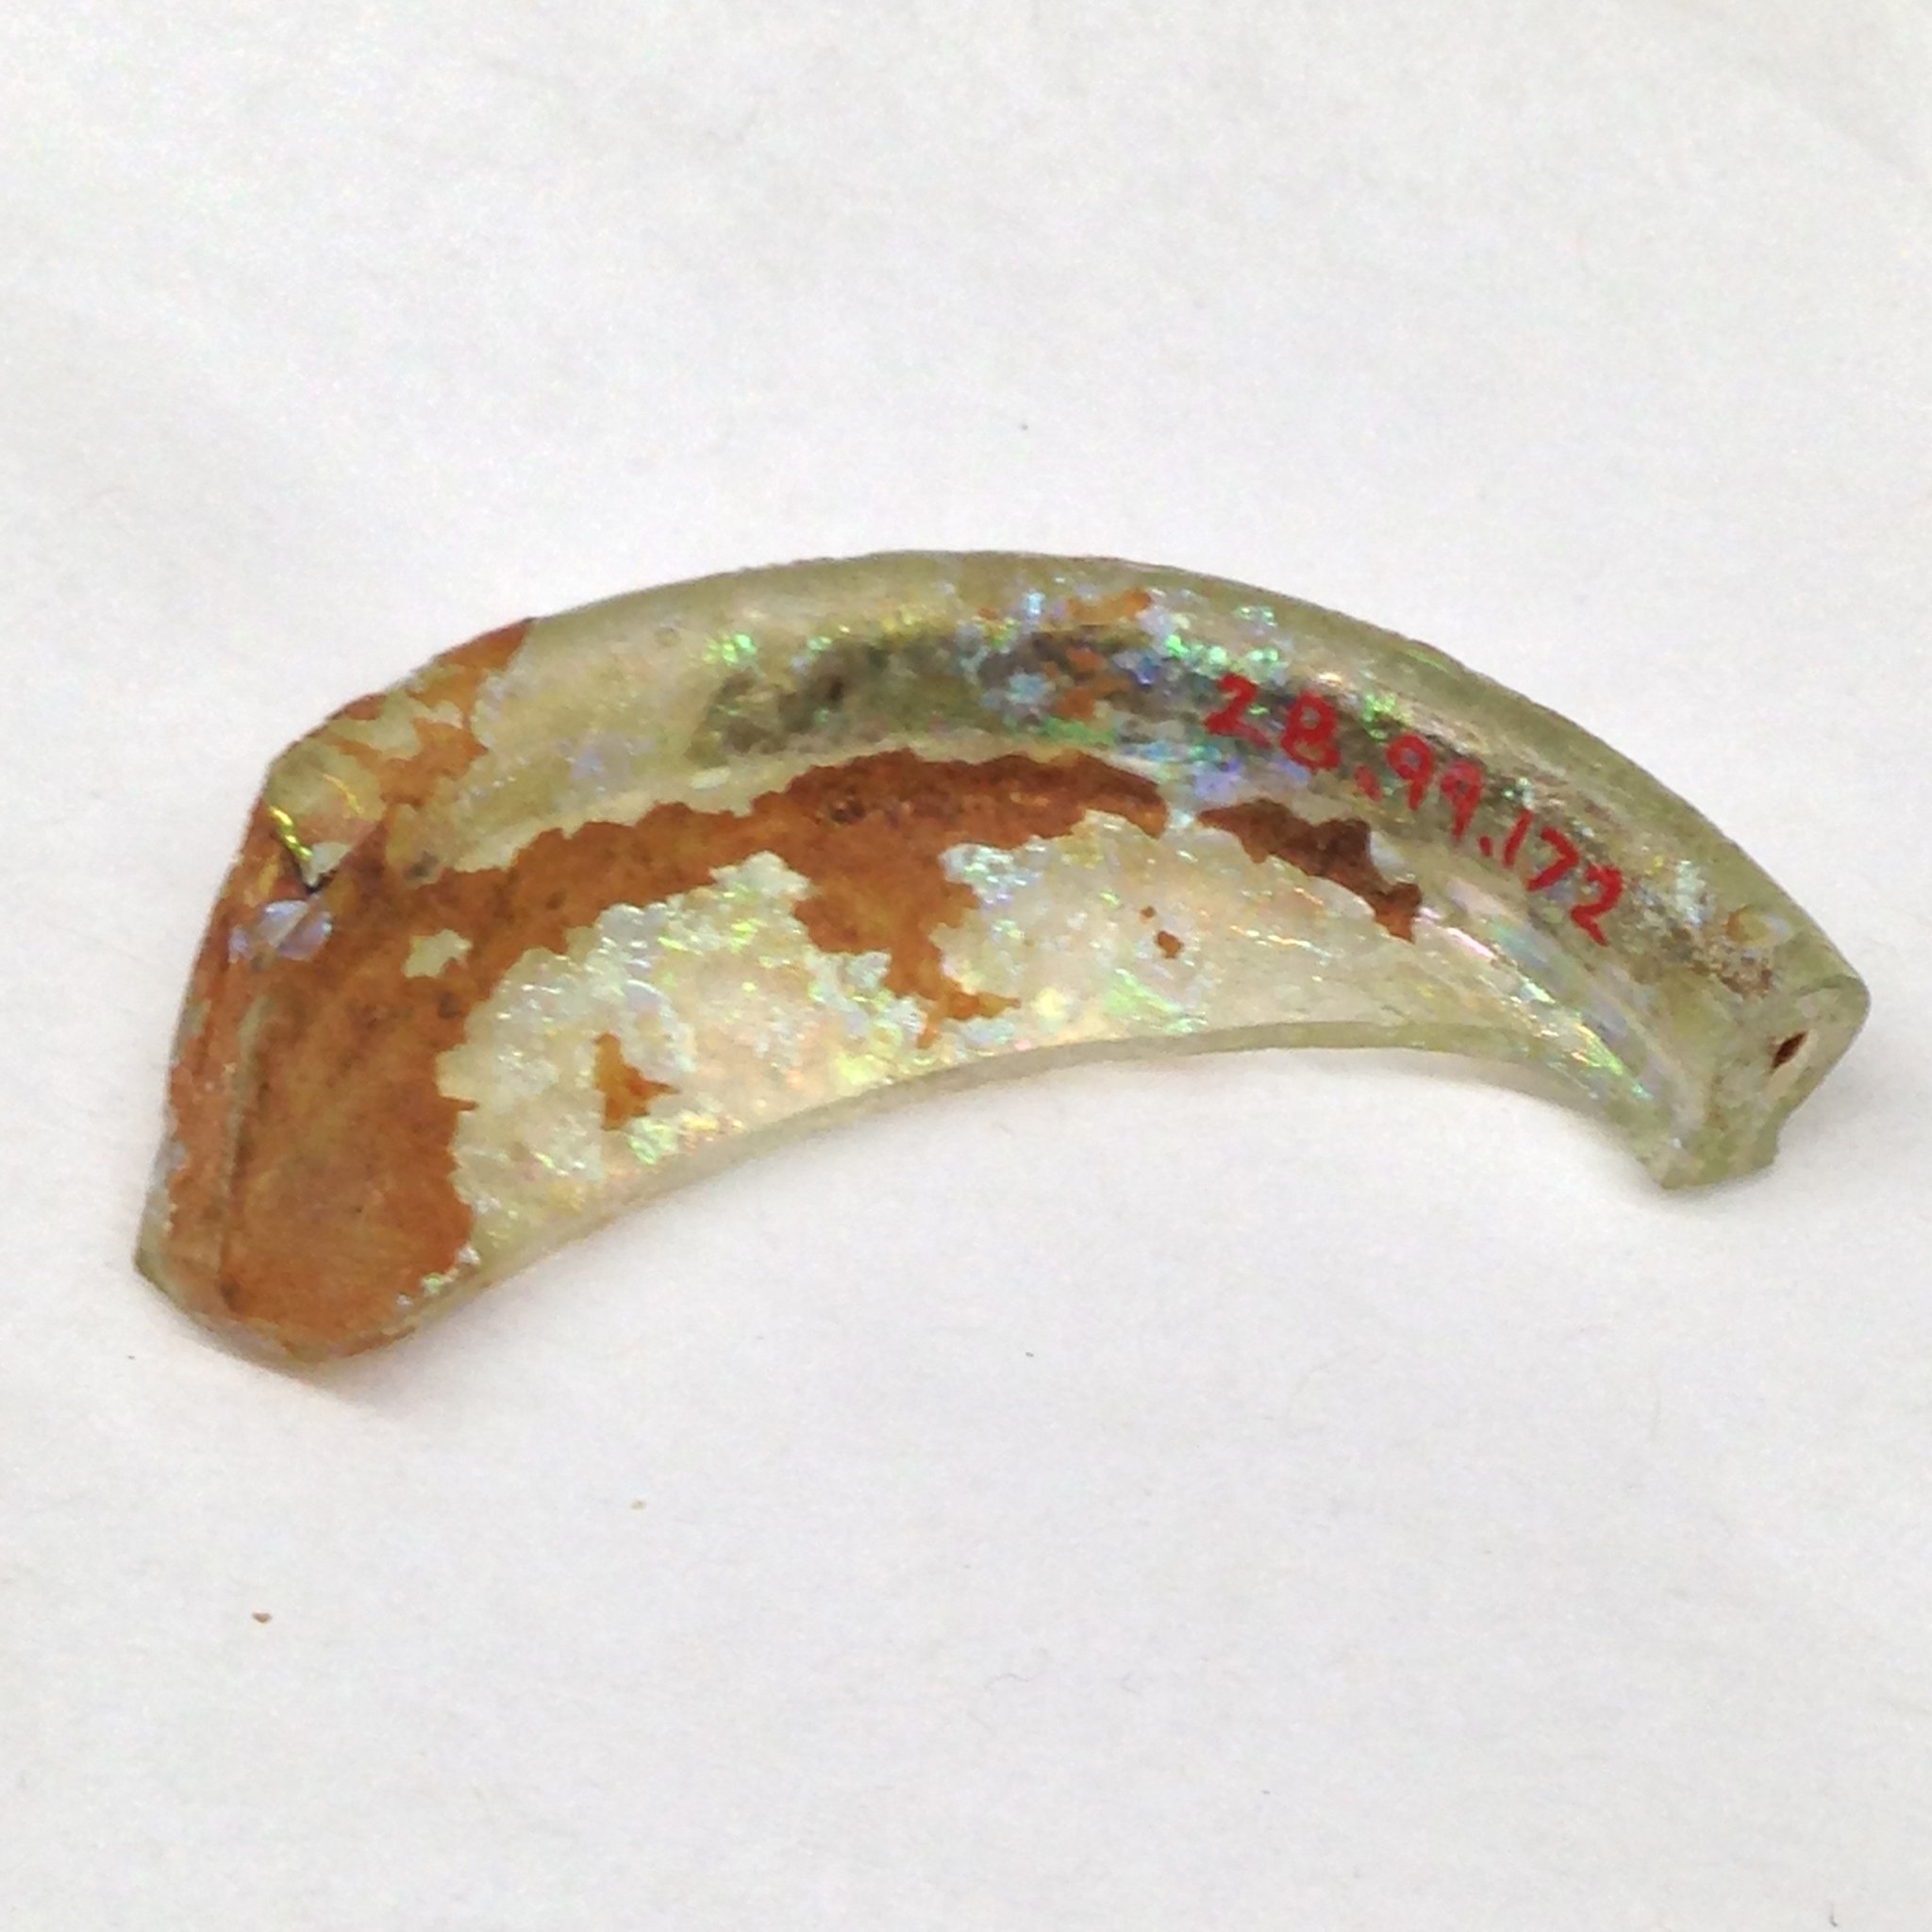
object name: fragment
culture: european or middle eastern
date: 1150-1250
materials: ceramic, glass